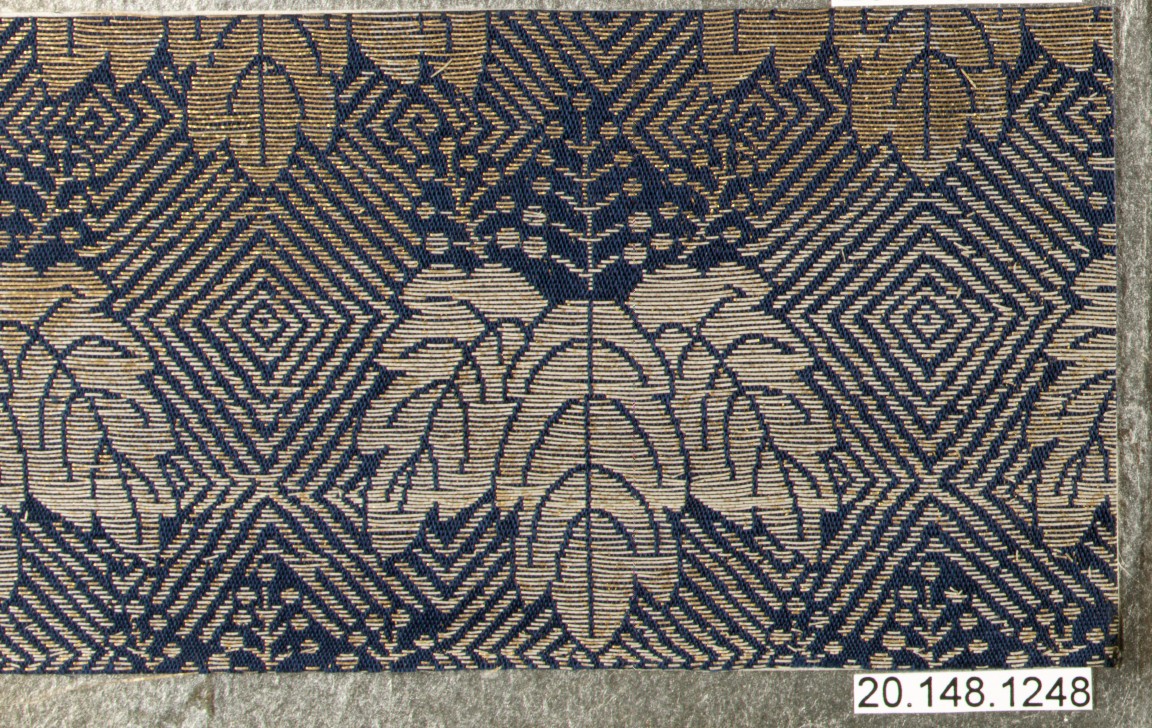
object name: piece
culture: japanese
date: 1801-1900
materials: silk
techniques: compound weave